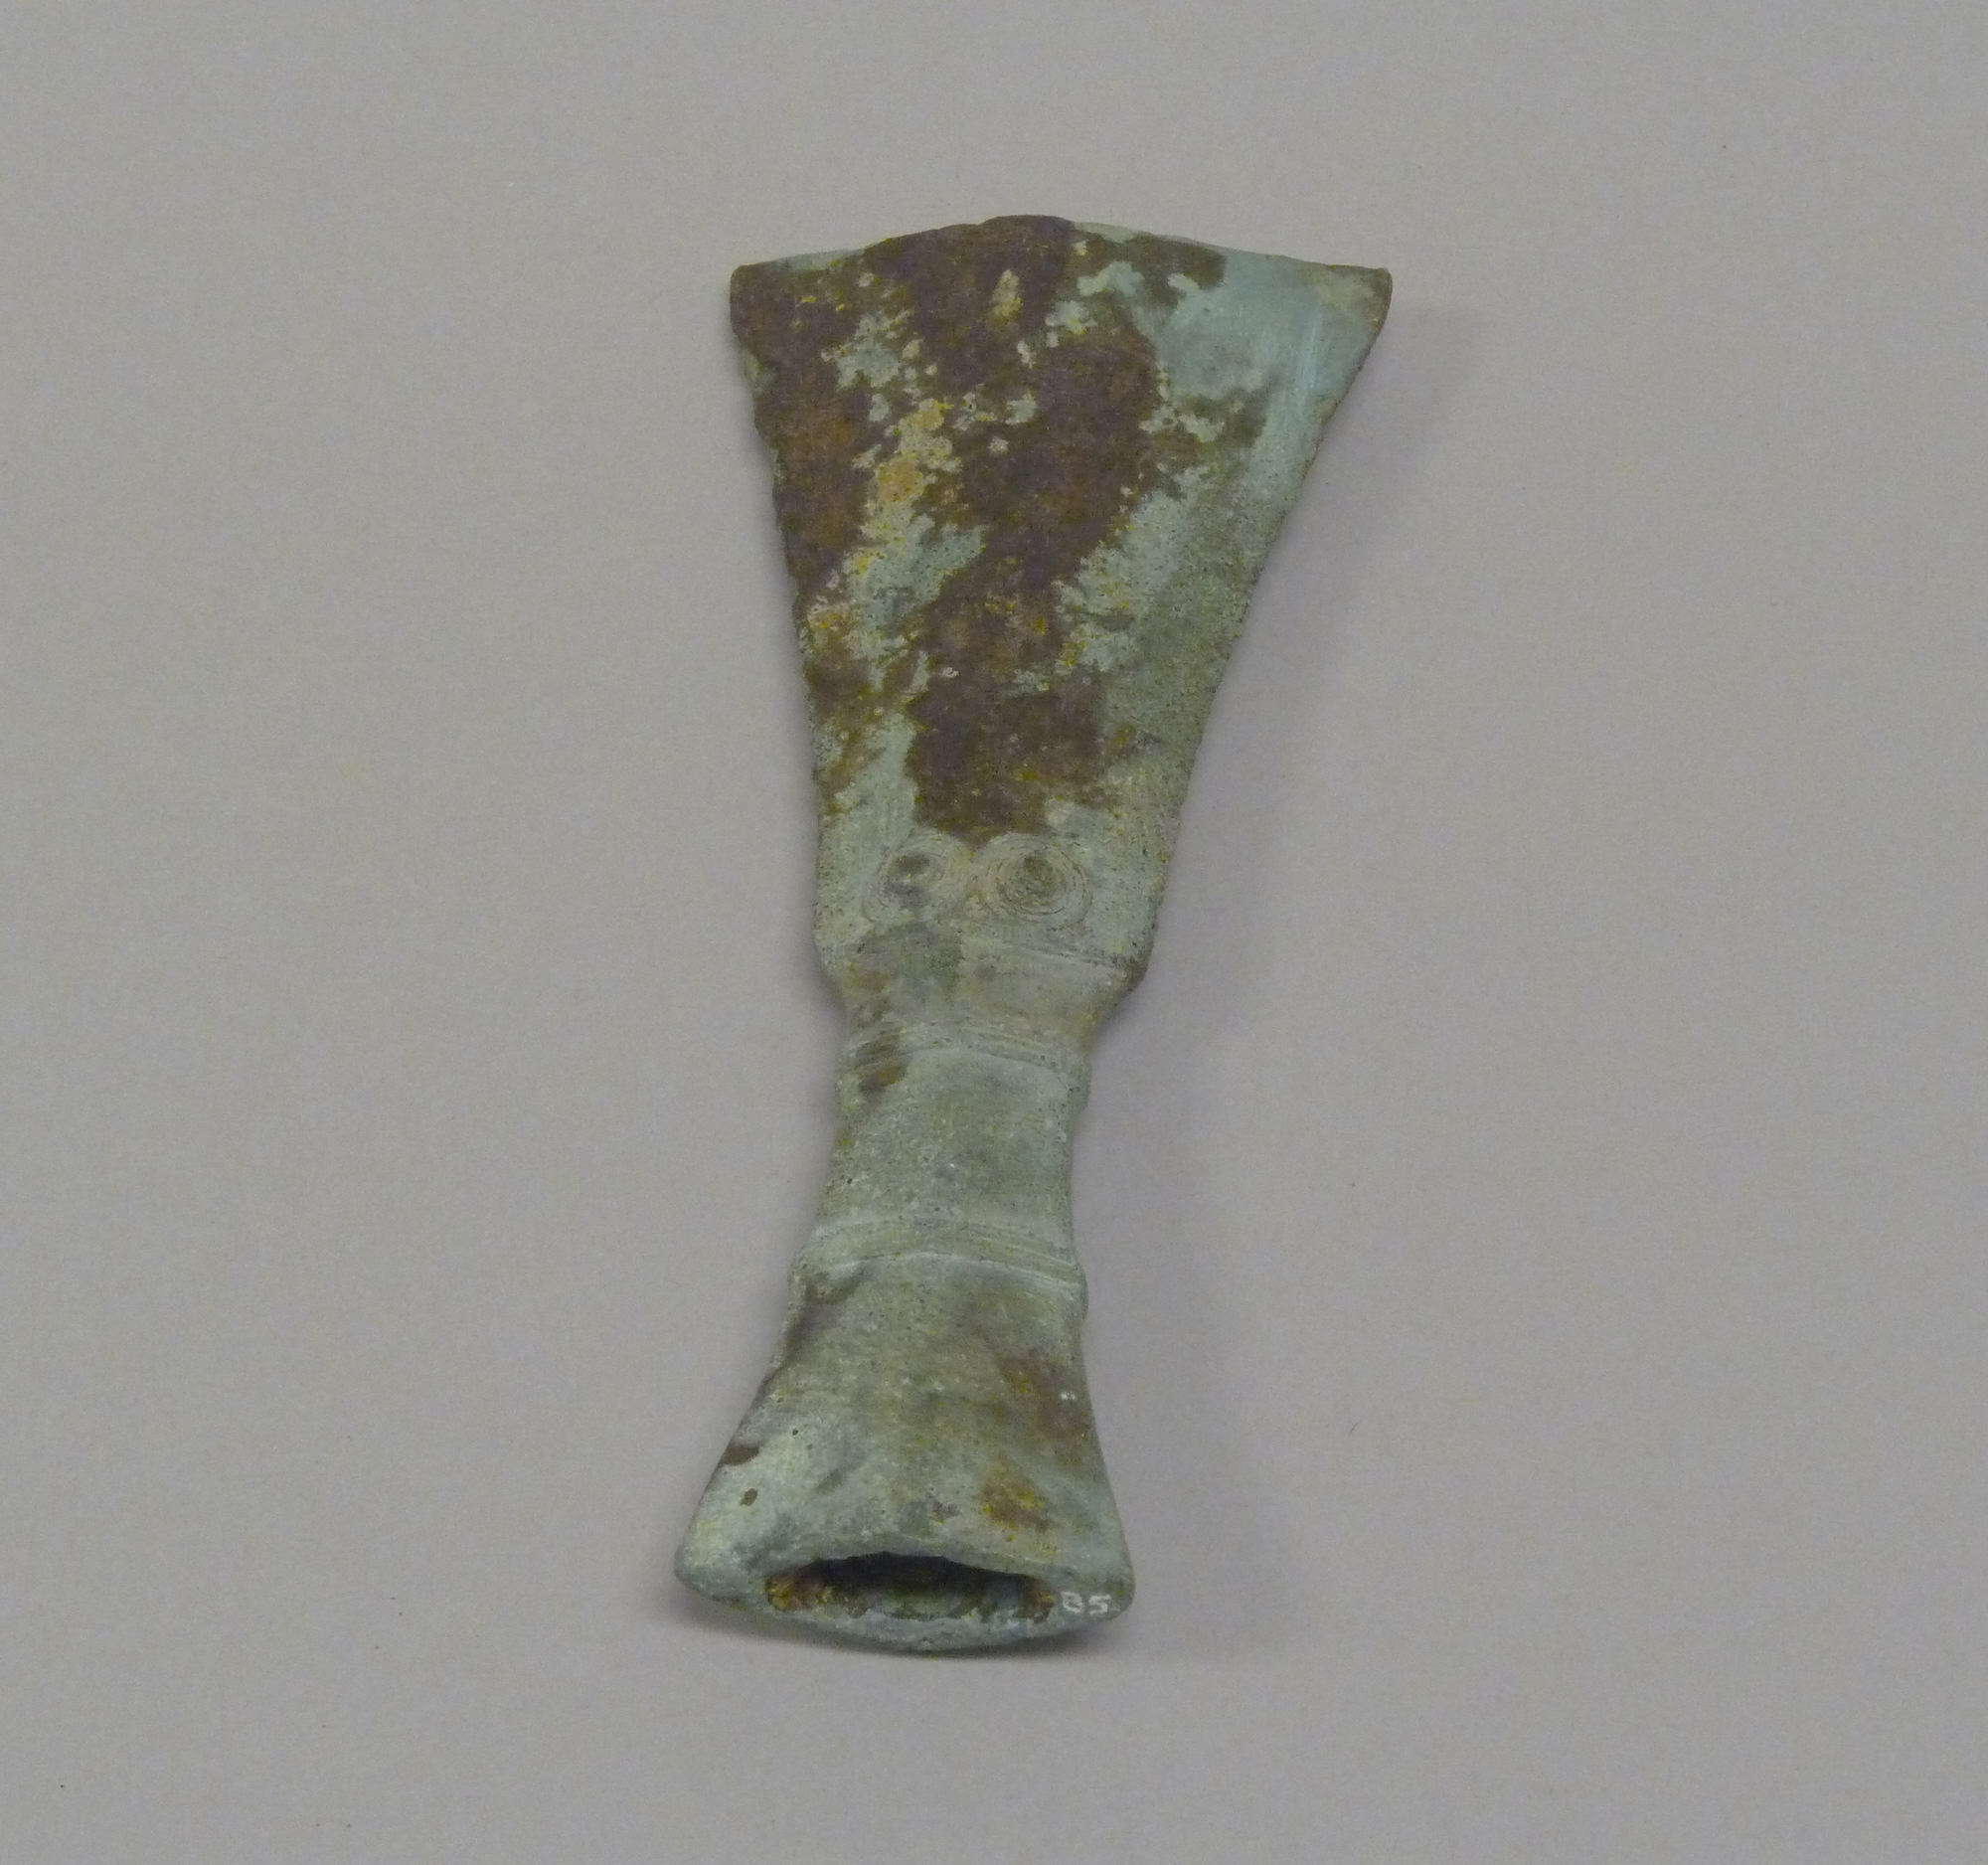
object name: knife handle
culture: indonesian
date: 500 BCE-300 CE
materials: bronze